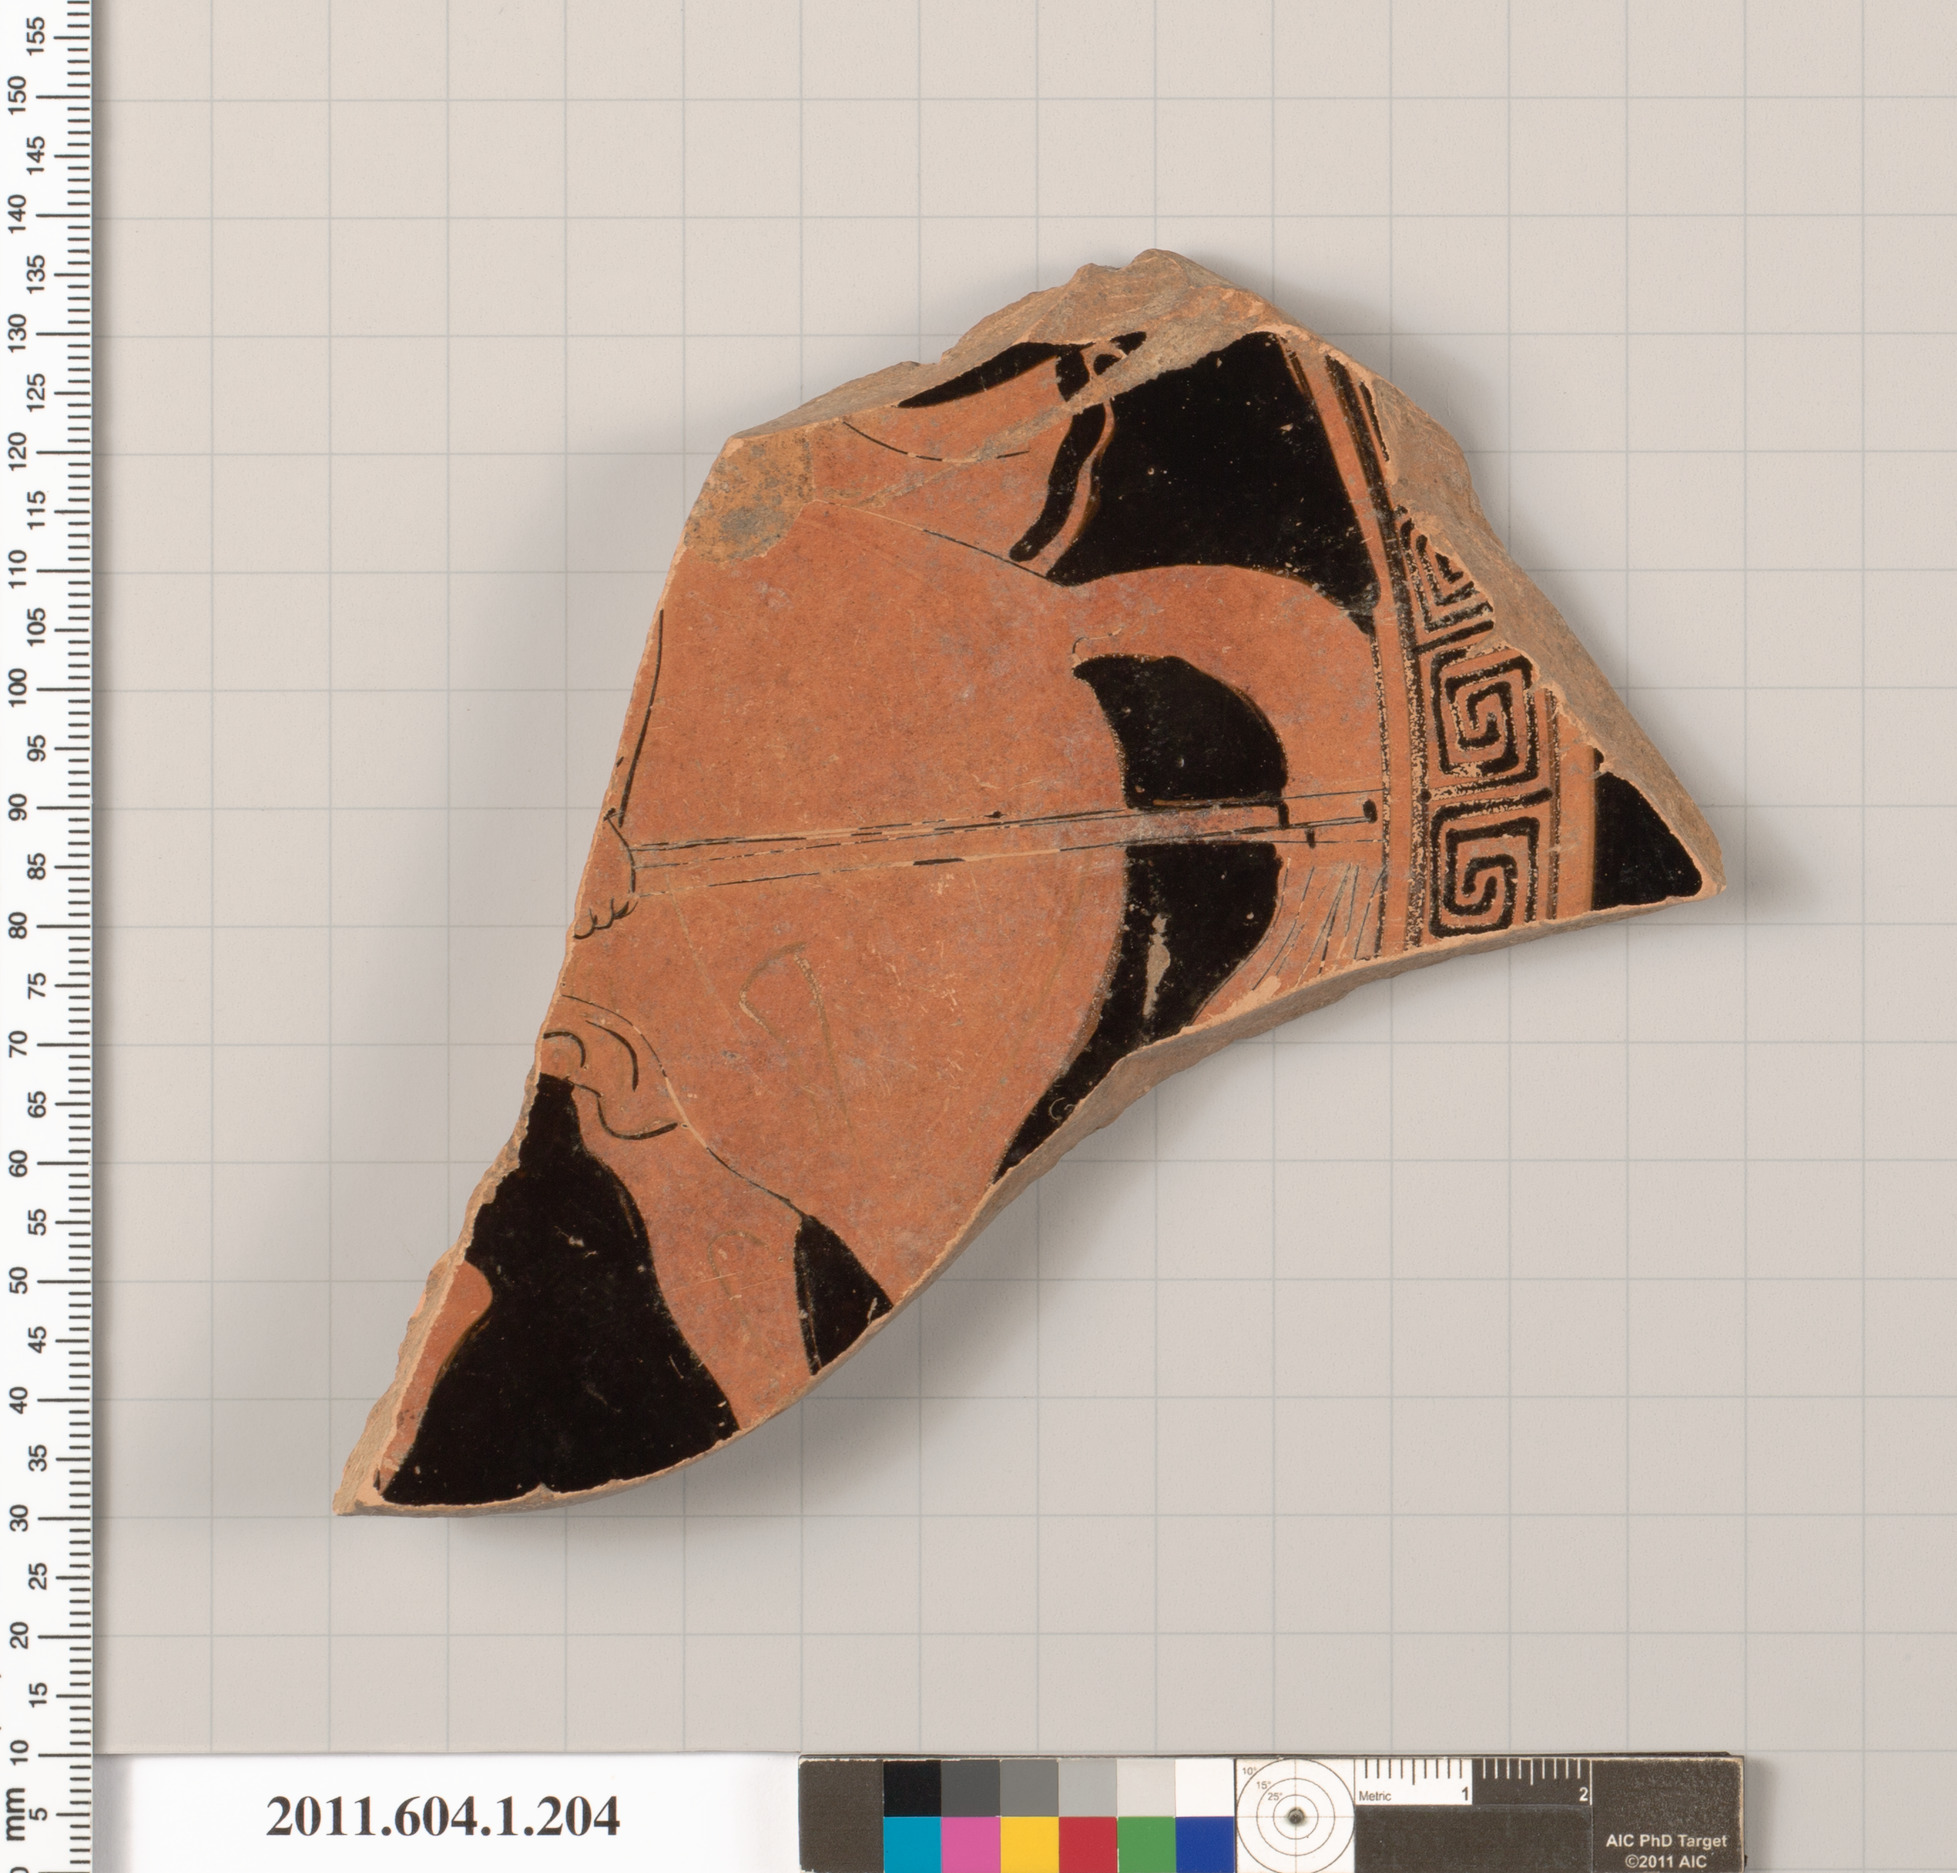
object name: kylix fragment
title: Terracotta fragment of a kylix (drinking cup)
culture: greek, attic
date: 475-451 BCE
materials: terracotta